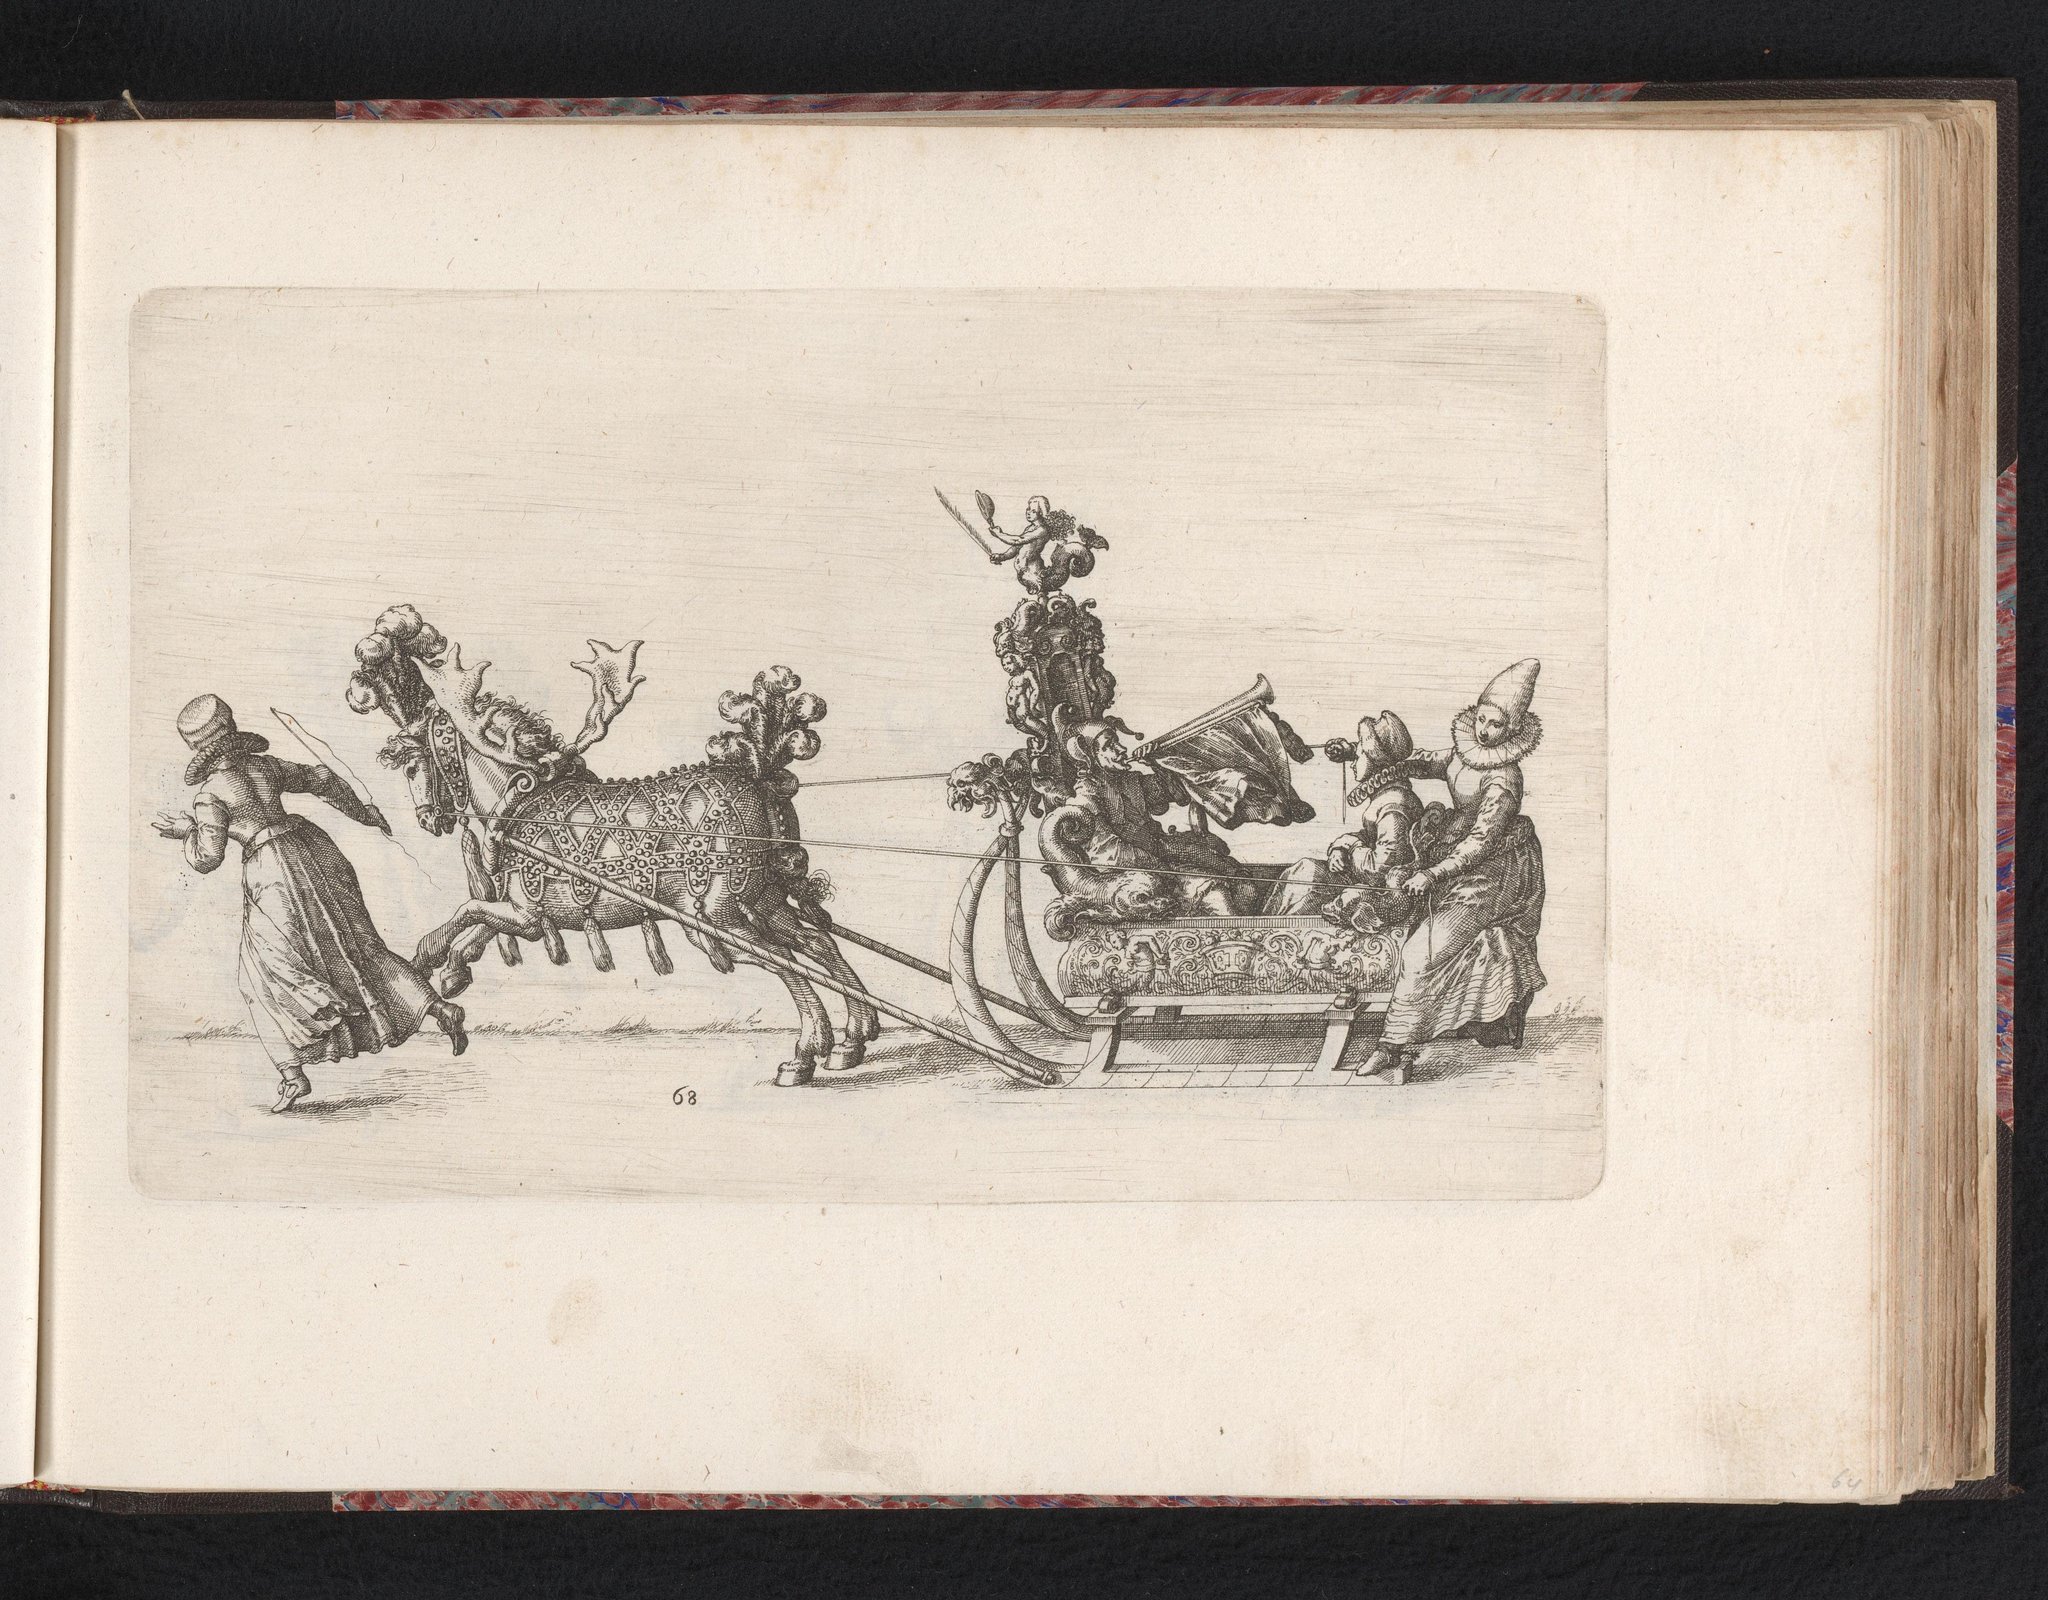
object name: album leaf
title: Aigentliche wahrhaffte Delineation unnd Abbildung aller fürstlichen Auffzüg und Rütterspilen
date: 1618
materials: paper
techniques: etching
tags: court jester, court fool, horse-sleigh, hoofed animals: elk - ff - fabulous animals (sometimes wrongly called 'grotesques'); 'mostri' (ripa), performance in the open air (pleasure fair)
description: Genummerd: 68. Deze prent maakt deel uit van een album.